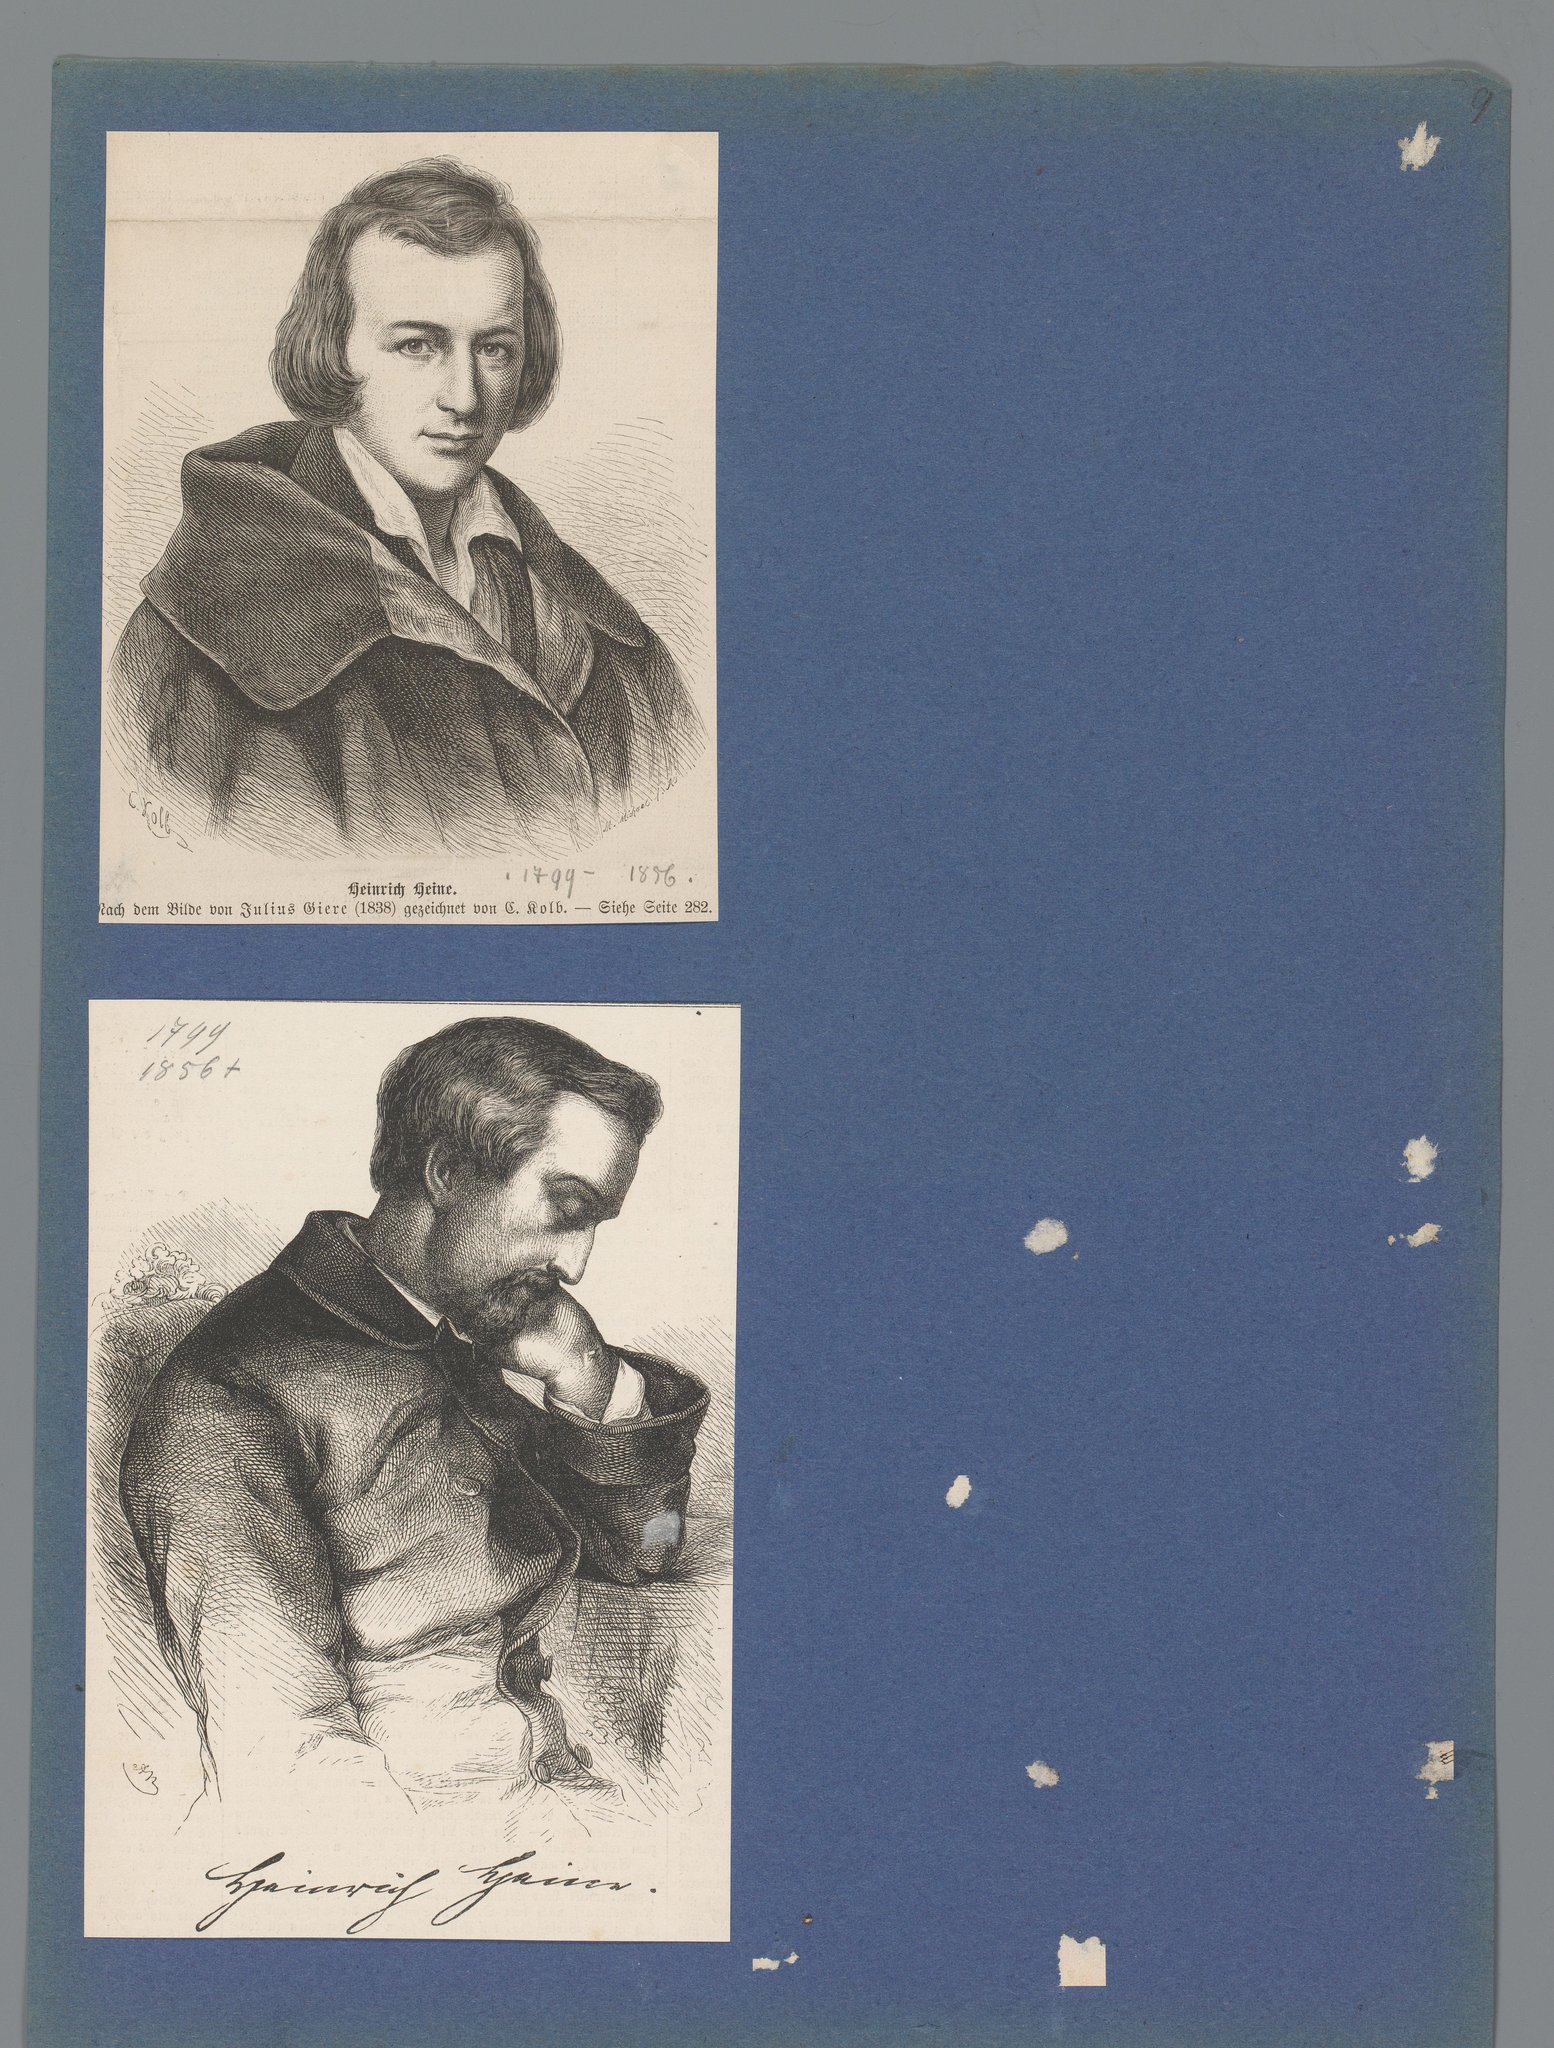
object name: print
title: Blad met twee portretten van Heinrich Heine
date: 1850-1900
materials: paper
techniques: letterpress printing, snipping, engraving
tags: paris, heinrich heine, historical persons, portrait of a writer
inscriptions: number: ‘9’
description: Met facsimile handtekening van geportretteerde.